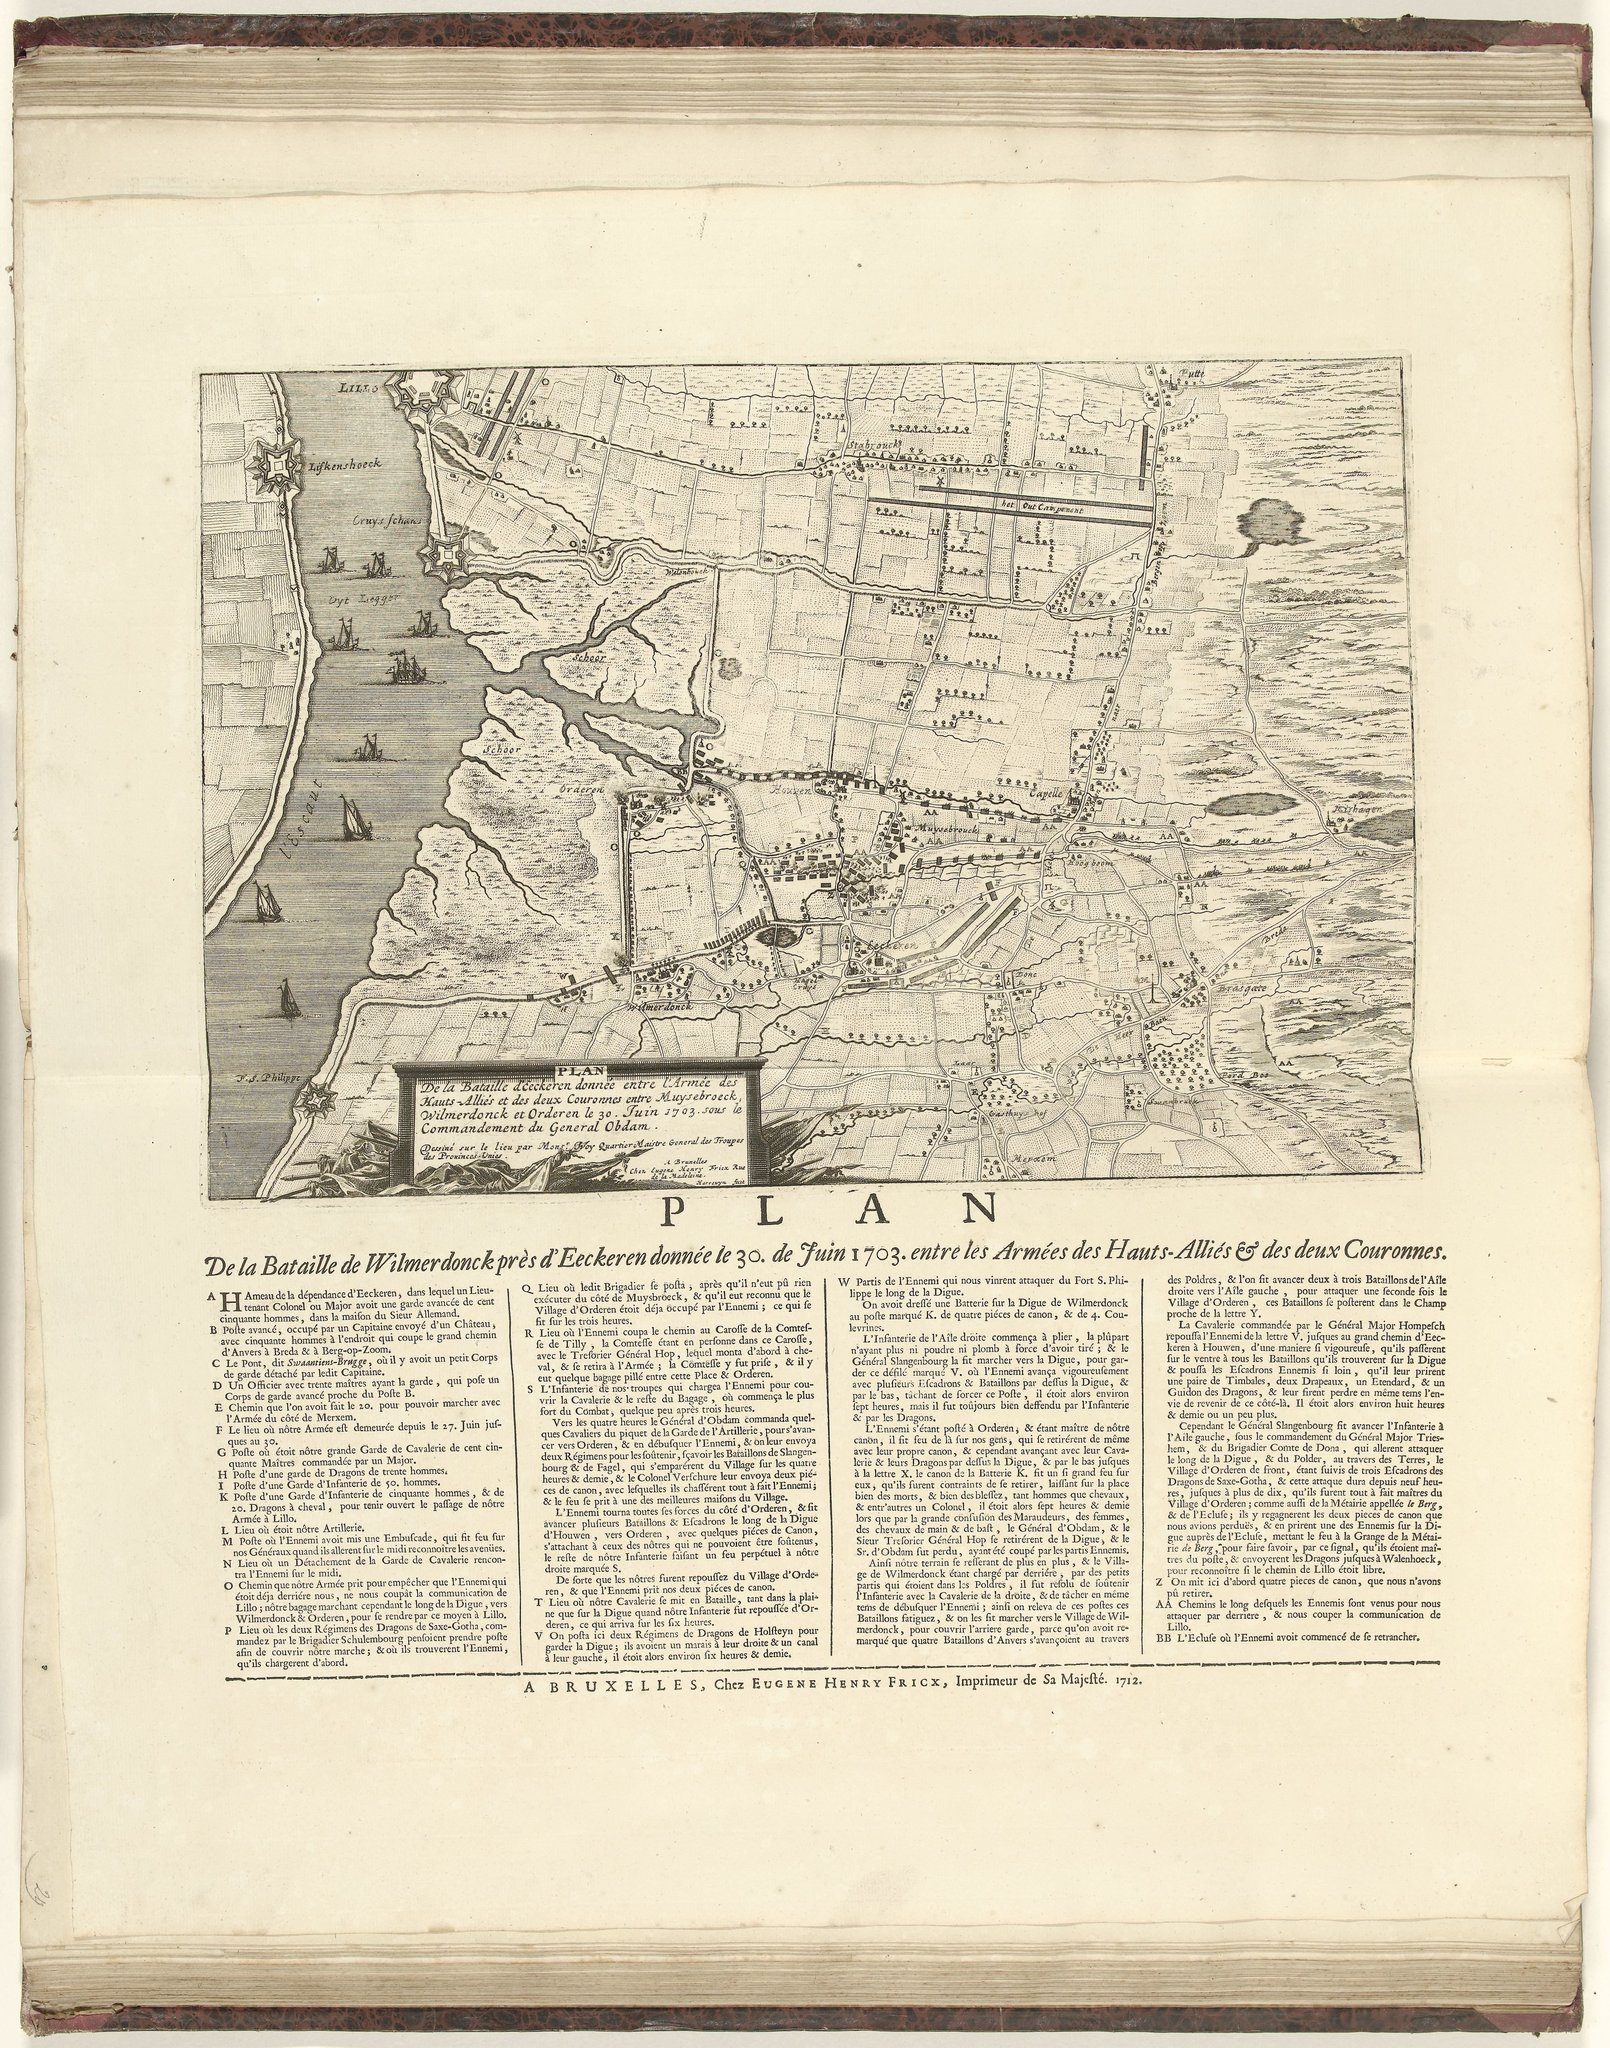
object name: map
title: Plan De la Bataille d'Eeckeren entre l'Armée des Hauts-Alliés et des deux Couronnes entre Muysebrock, Wilmerdonck et Orderen le 30. Juin 1703. sous le Commandement du General Obdam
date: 1703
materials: paper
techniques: etching, letterpress printing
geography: brussels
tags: maps of separate countries or regions, battle (+ land forces)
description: Slag bij Ekeren. Overwinning van een Frans leger op de Nederlanders onder Jacob II van Wassenaer Obdam bij Ekeren, 30 juni 1703. Op het blad onder de plaat staat een gedrukte verklaring van de voorstelling in het Frans. Onderdeel van een gebundelde verzameling van plannen van veldslagen en steden vermaard in de Spaanse Successieoorlog.